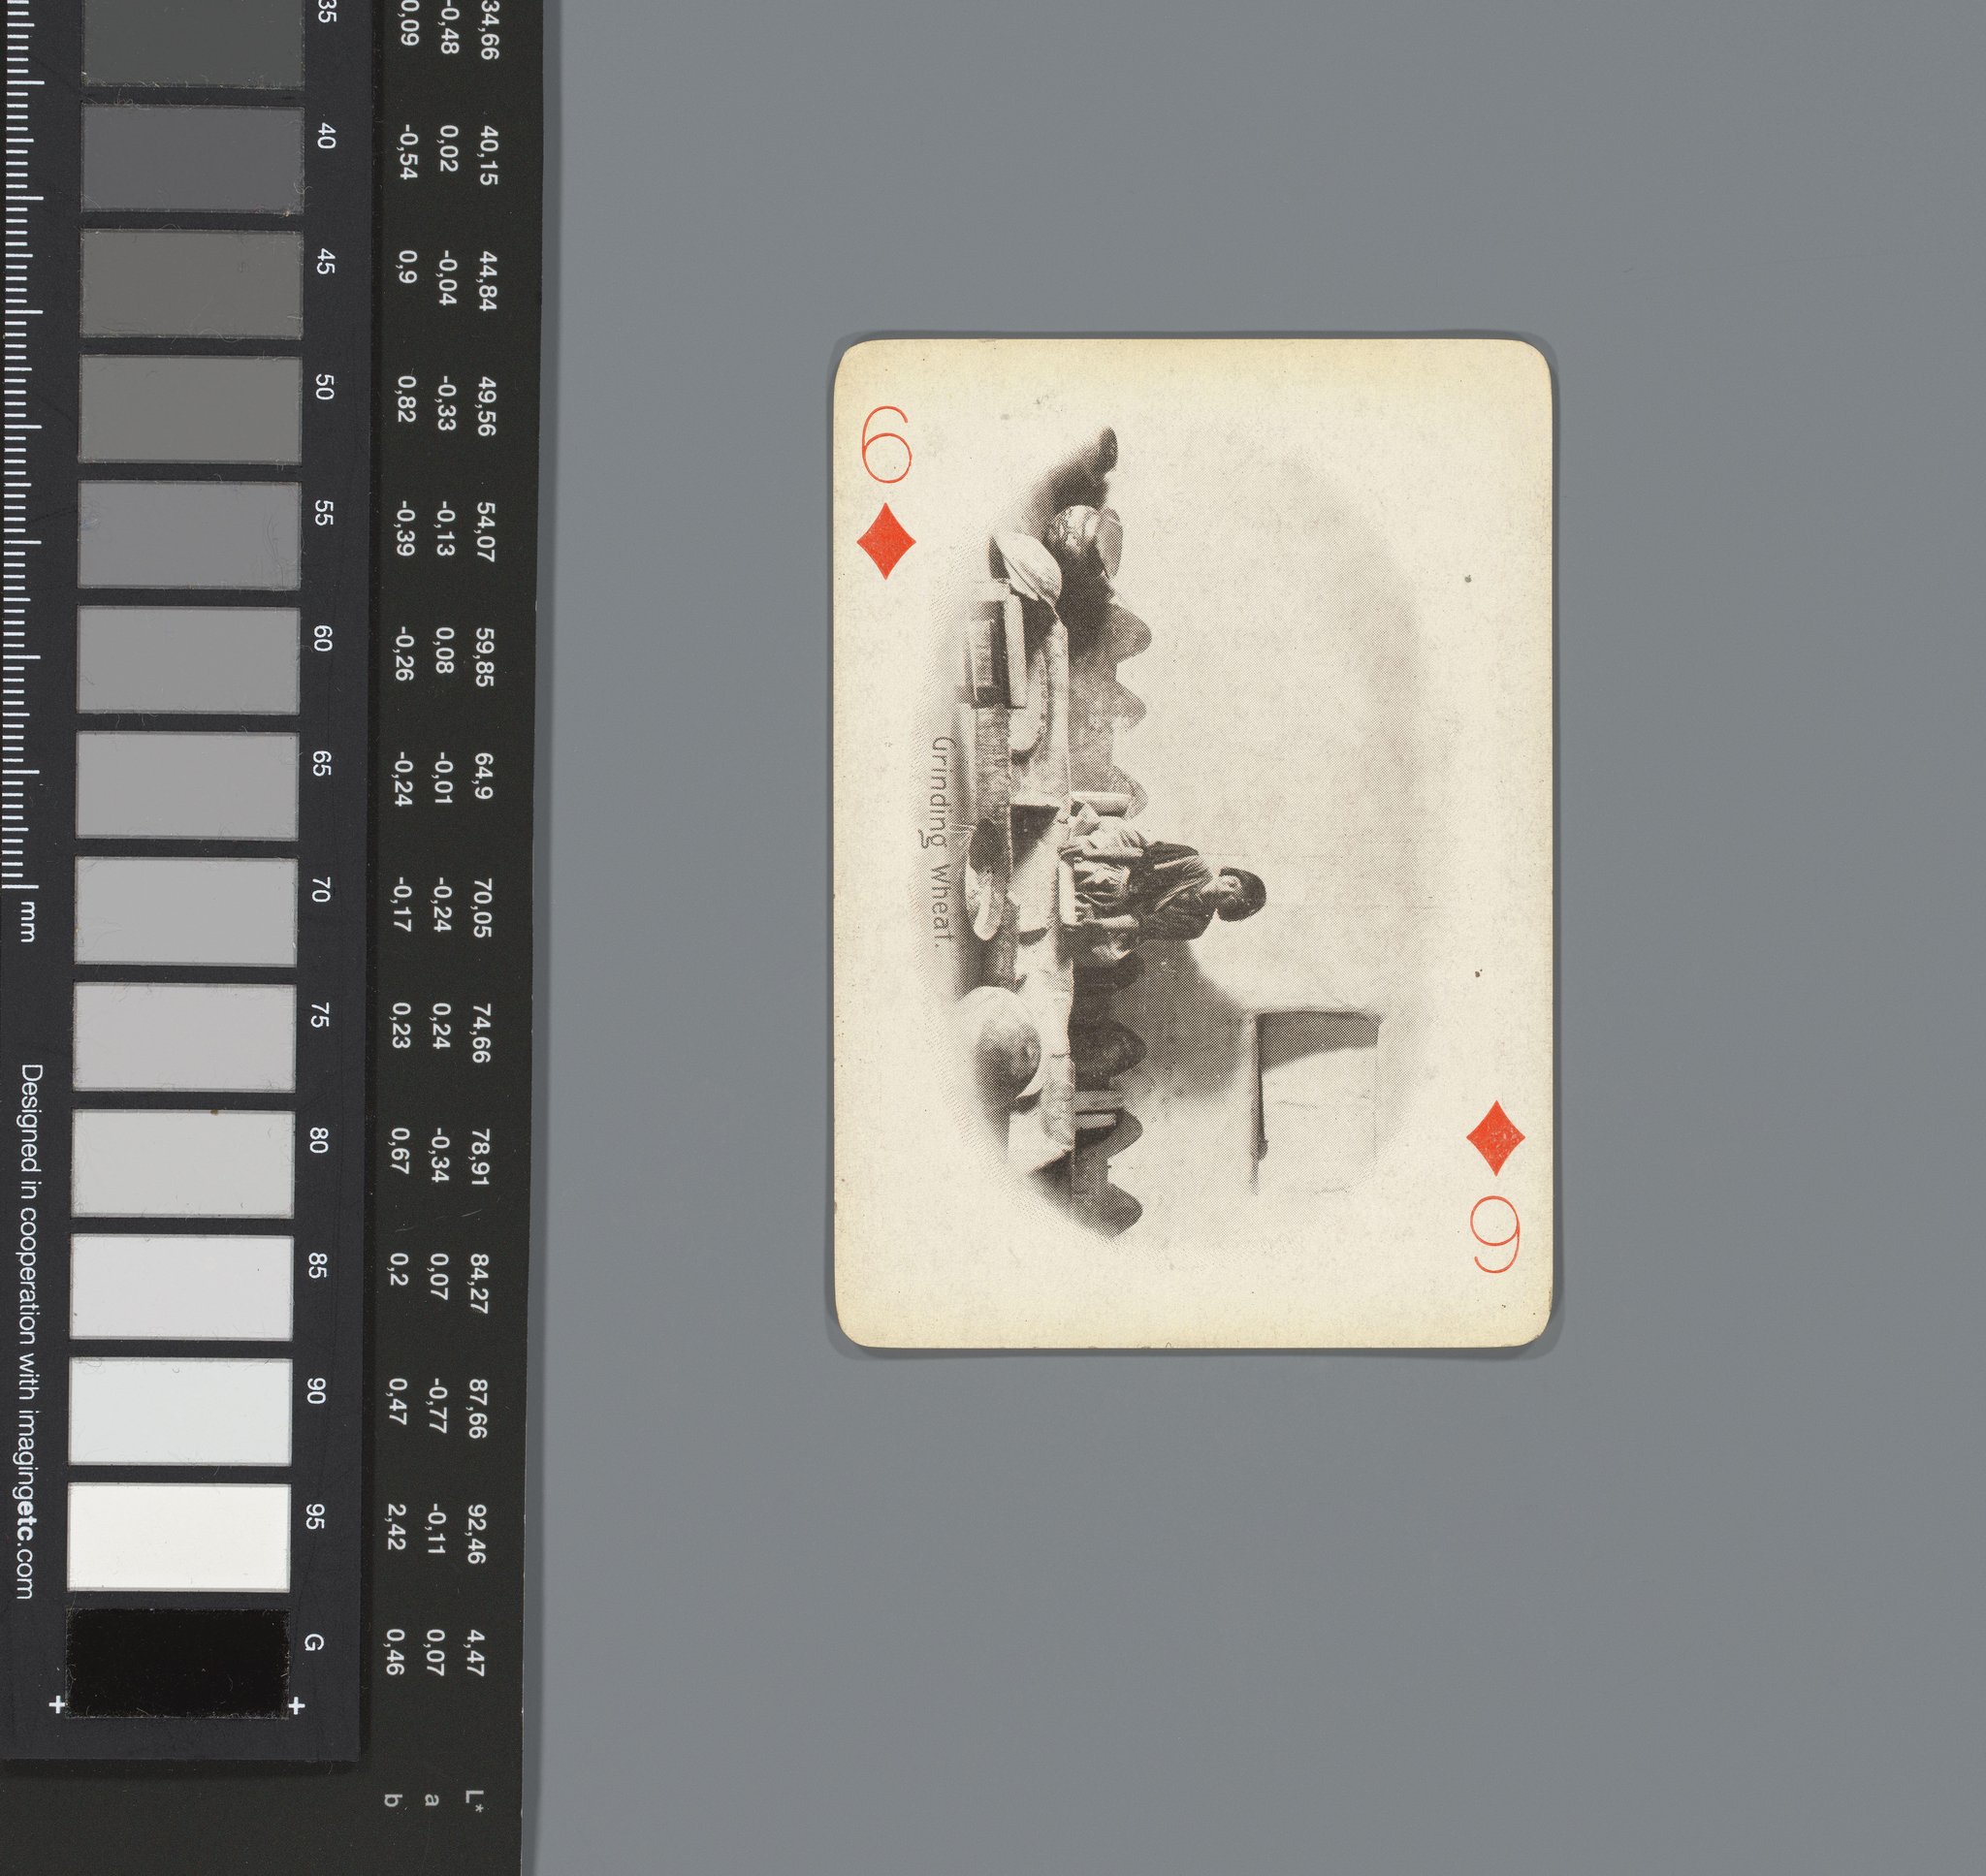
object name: photograph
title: Ruiten zes met vrouw die tarwe maalt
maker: adam clark vroman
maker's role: fotograaf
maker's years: 1856-1916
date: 1900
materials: paper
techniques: autotype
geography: united states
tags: united states of america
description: Speelkaart uit doosje met 53 speelkaarten met afbeeldingen in autotypie van Native Americans. De inhoud bevat een complete set speelkaarten inclusief joker.